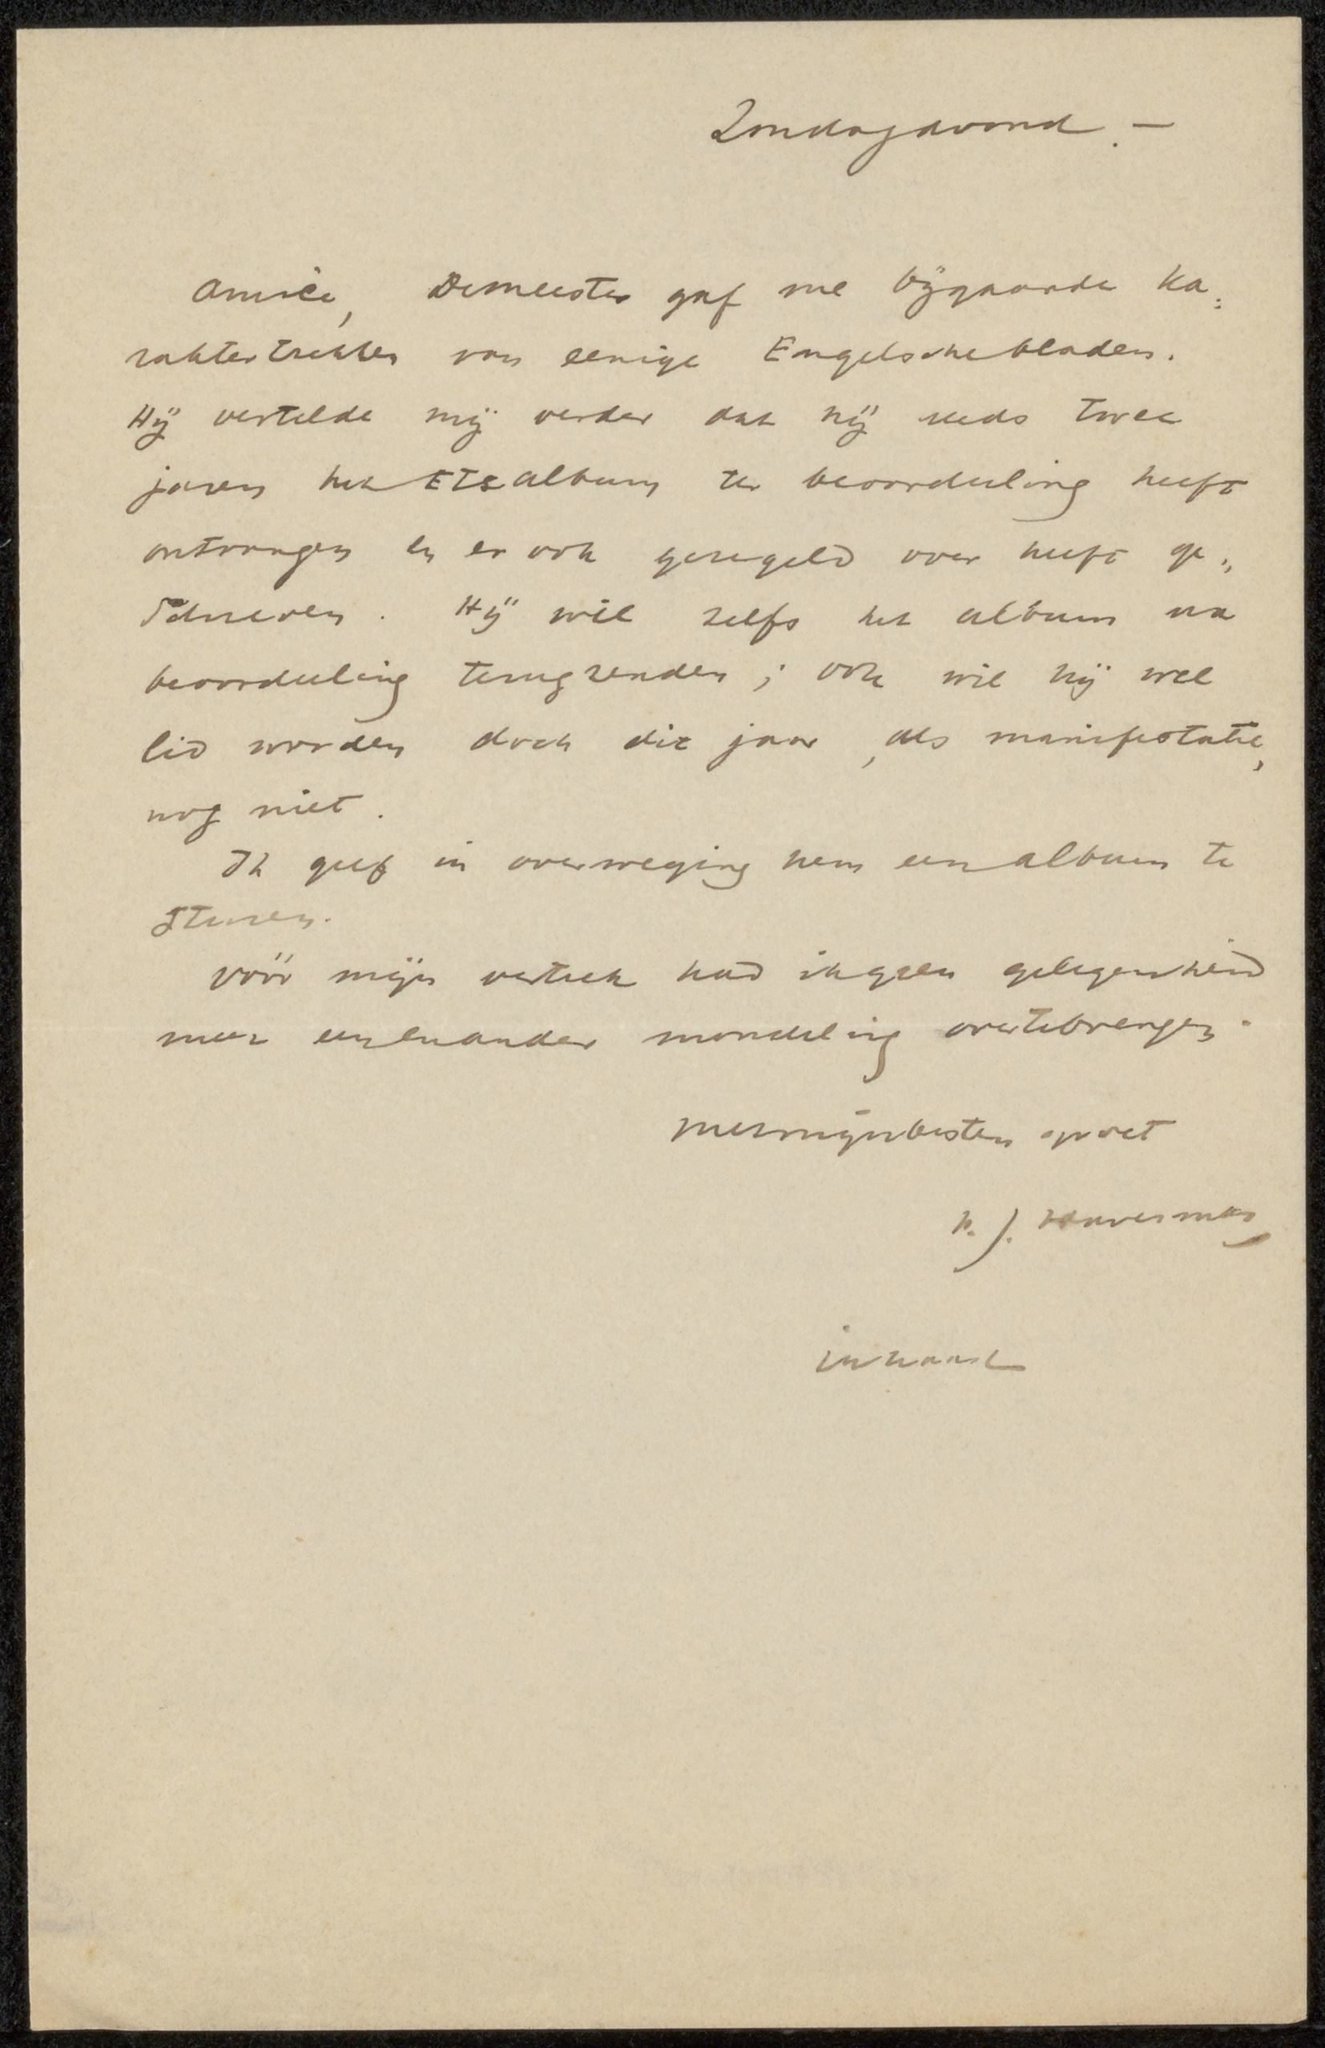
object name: letter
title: Brief aan Philip Zilcken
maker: hendrik johannes haverman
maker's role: draughtsman, print maker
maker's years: 1857-1928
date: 1867-1928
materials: ink, paper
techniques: pen, writing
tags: painter, philip zilcken, literature ~ arts, the graphic arts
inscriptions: collector's mark: ‘RPK’